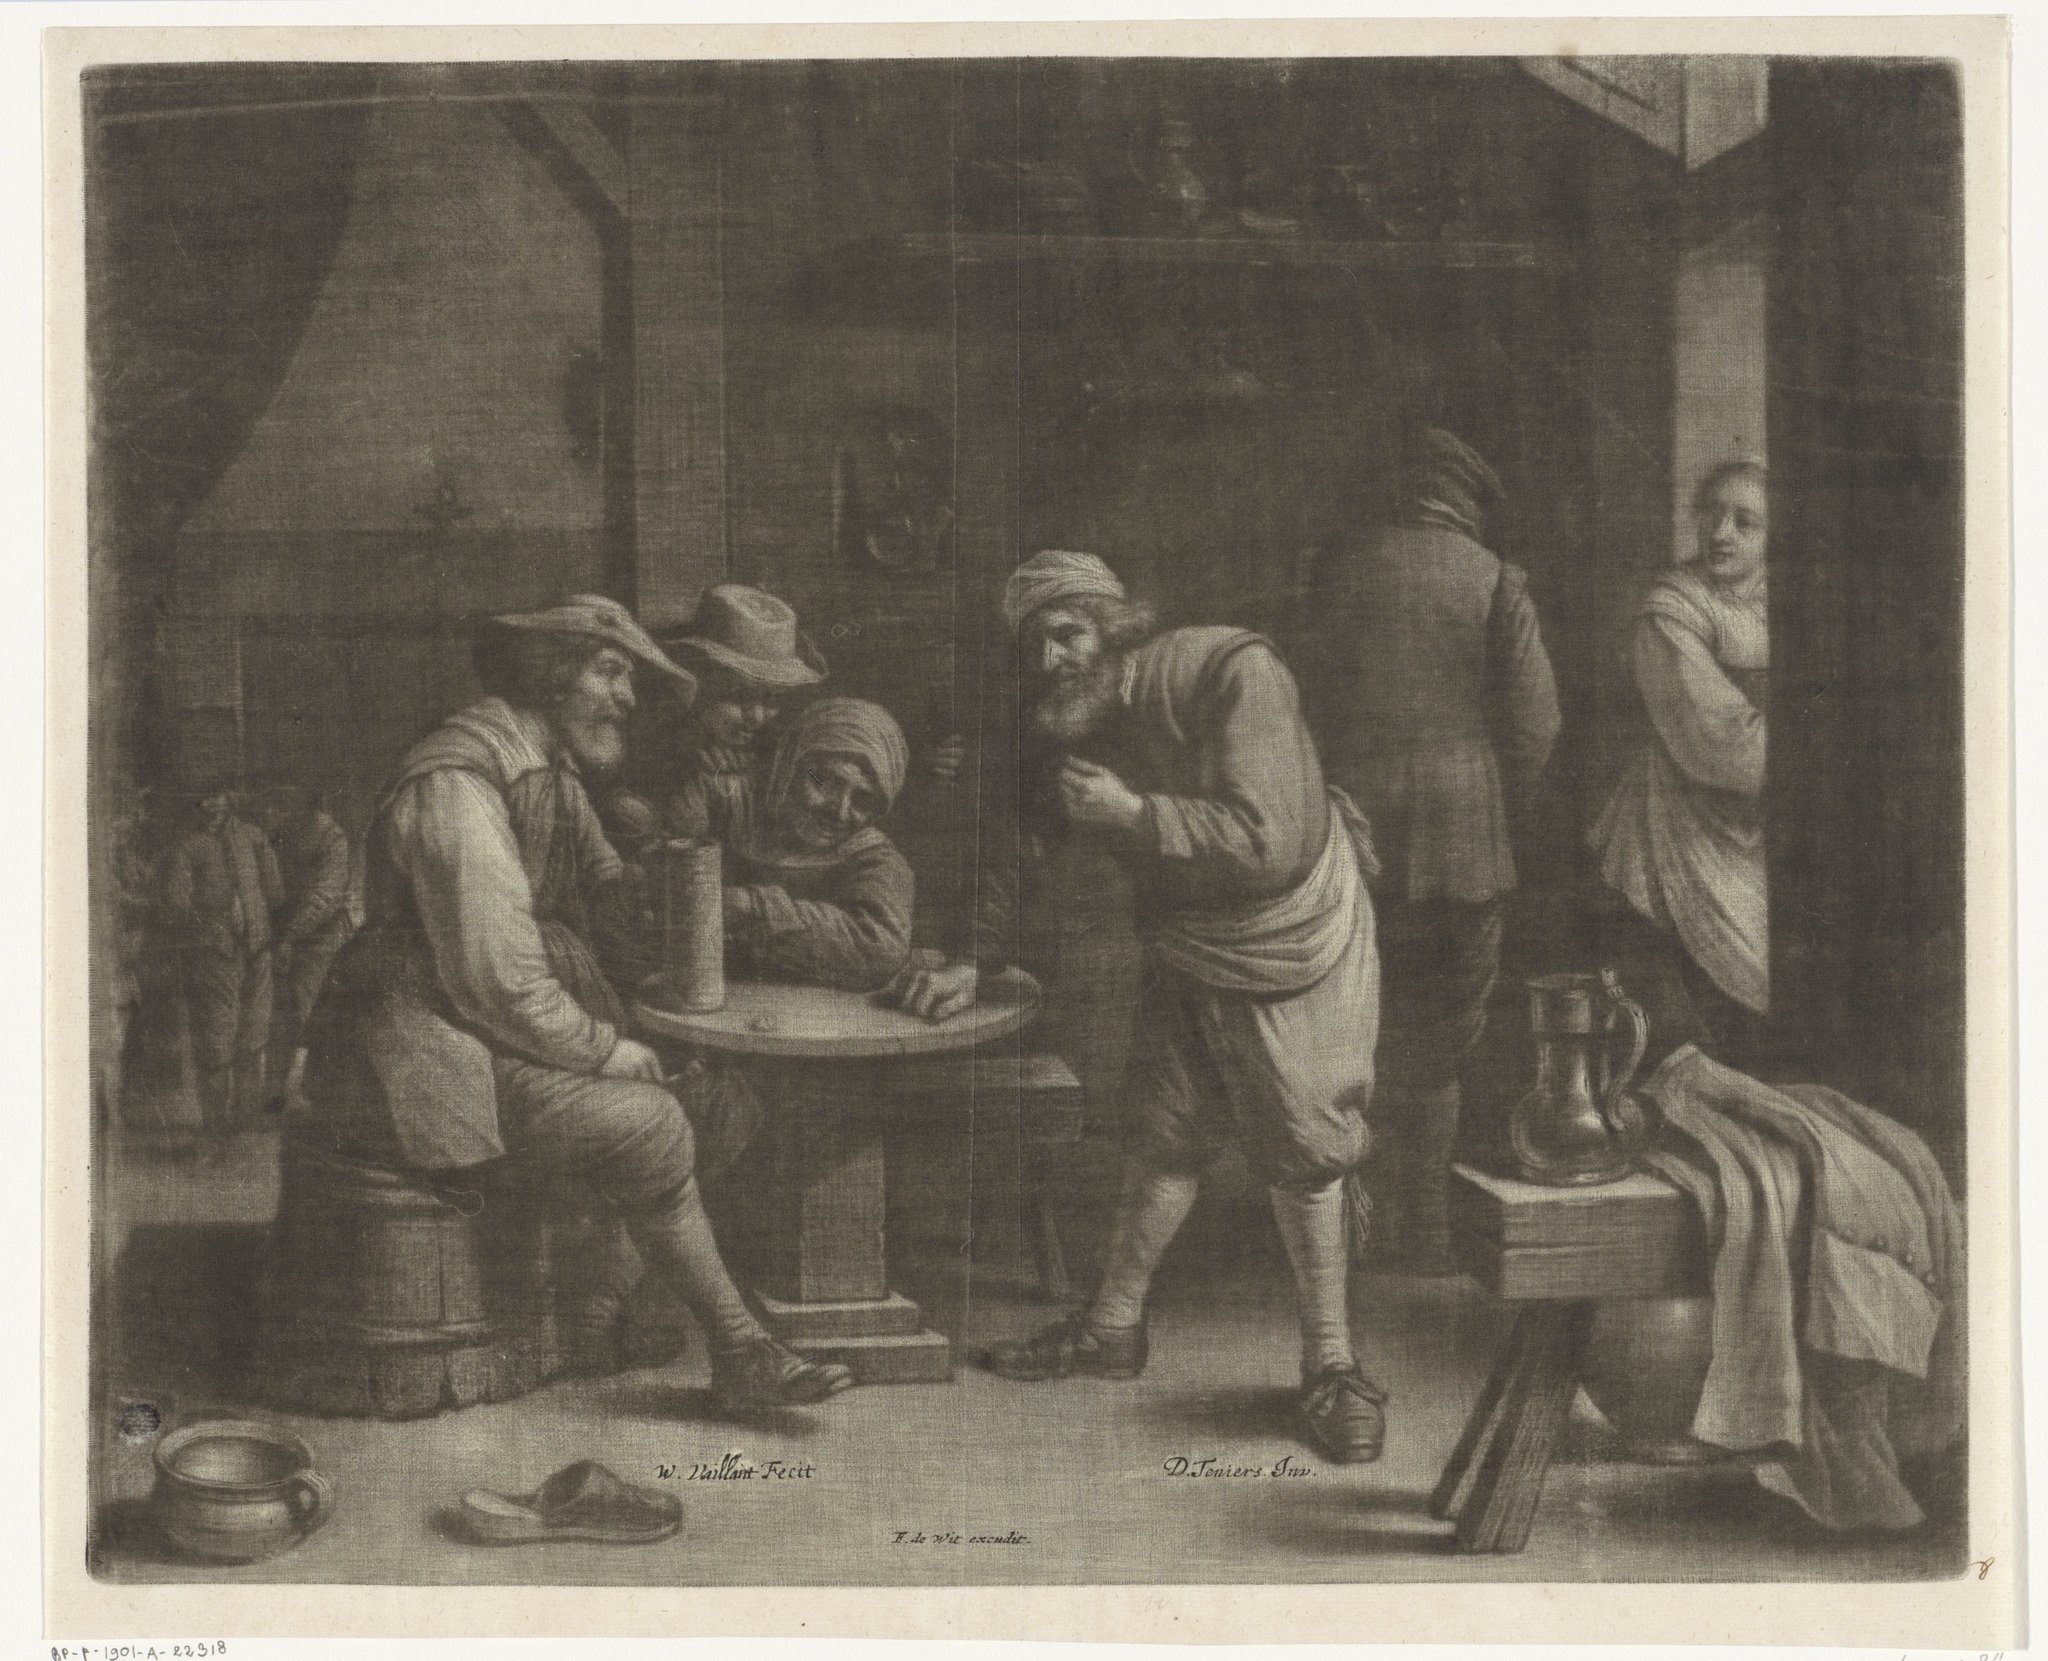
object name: print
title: Herbergscène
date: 1658-1706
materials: paper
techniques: mezzotint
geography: amsterdam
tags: inn, coffee-house, public house, etc., pipe ~ tobacco, conversation, dialogue; conversation piece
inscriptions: collector's mark: Lugt 2228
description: In een herberg voeren enkele mannen een gesprek rond een tafeltje. Op de achtergrond vermaken anderen zich.